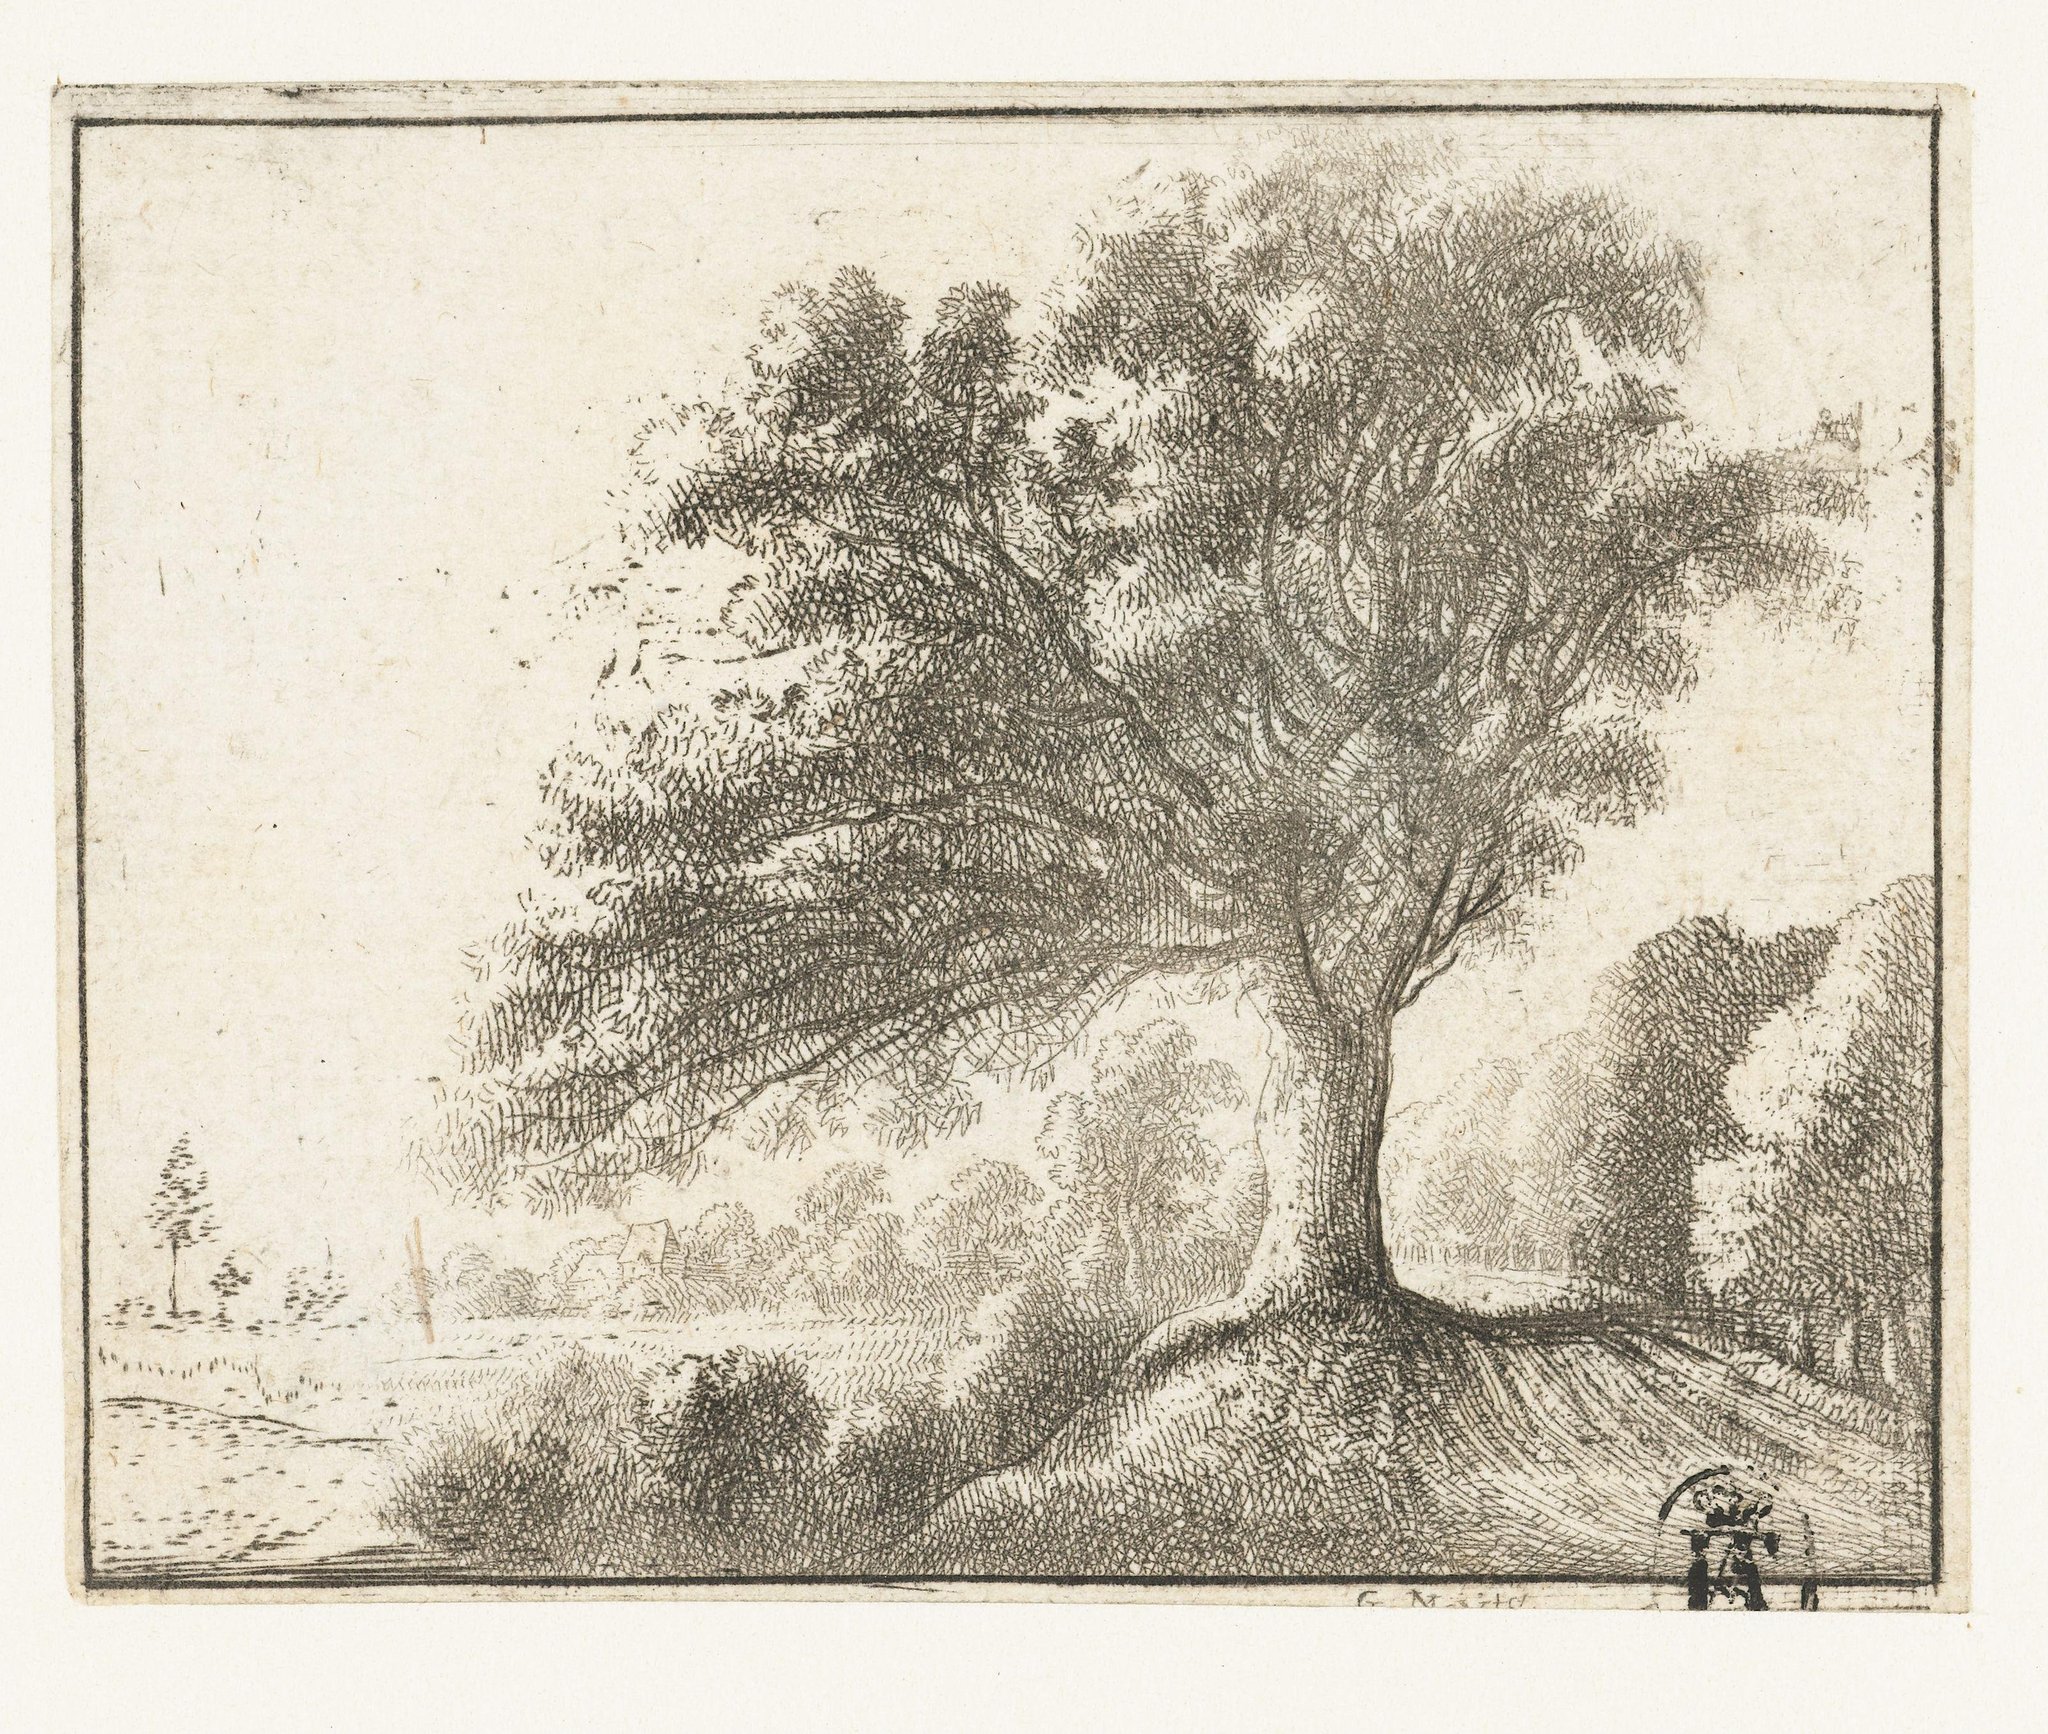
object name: print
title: Landschap met grote boom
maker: gilles neyts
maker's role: draughtsman, print maker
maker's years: 1623-1687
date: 1643-1681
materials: paper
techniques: etching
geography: antwerp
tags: landscapes in the temperate zone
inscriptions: collector's mark: Lugt 971, collector's mark: Lugt 2228a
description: Bomenrijk landschap. Een grote boom aan een laan op de voorgrond.